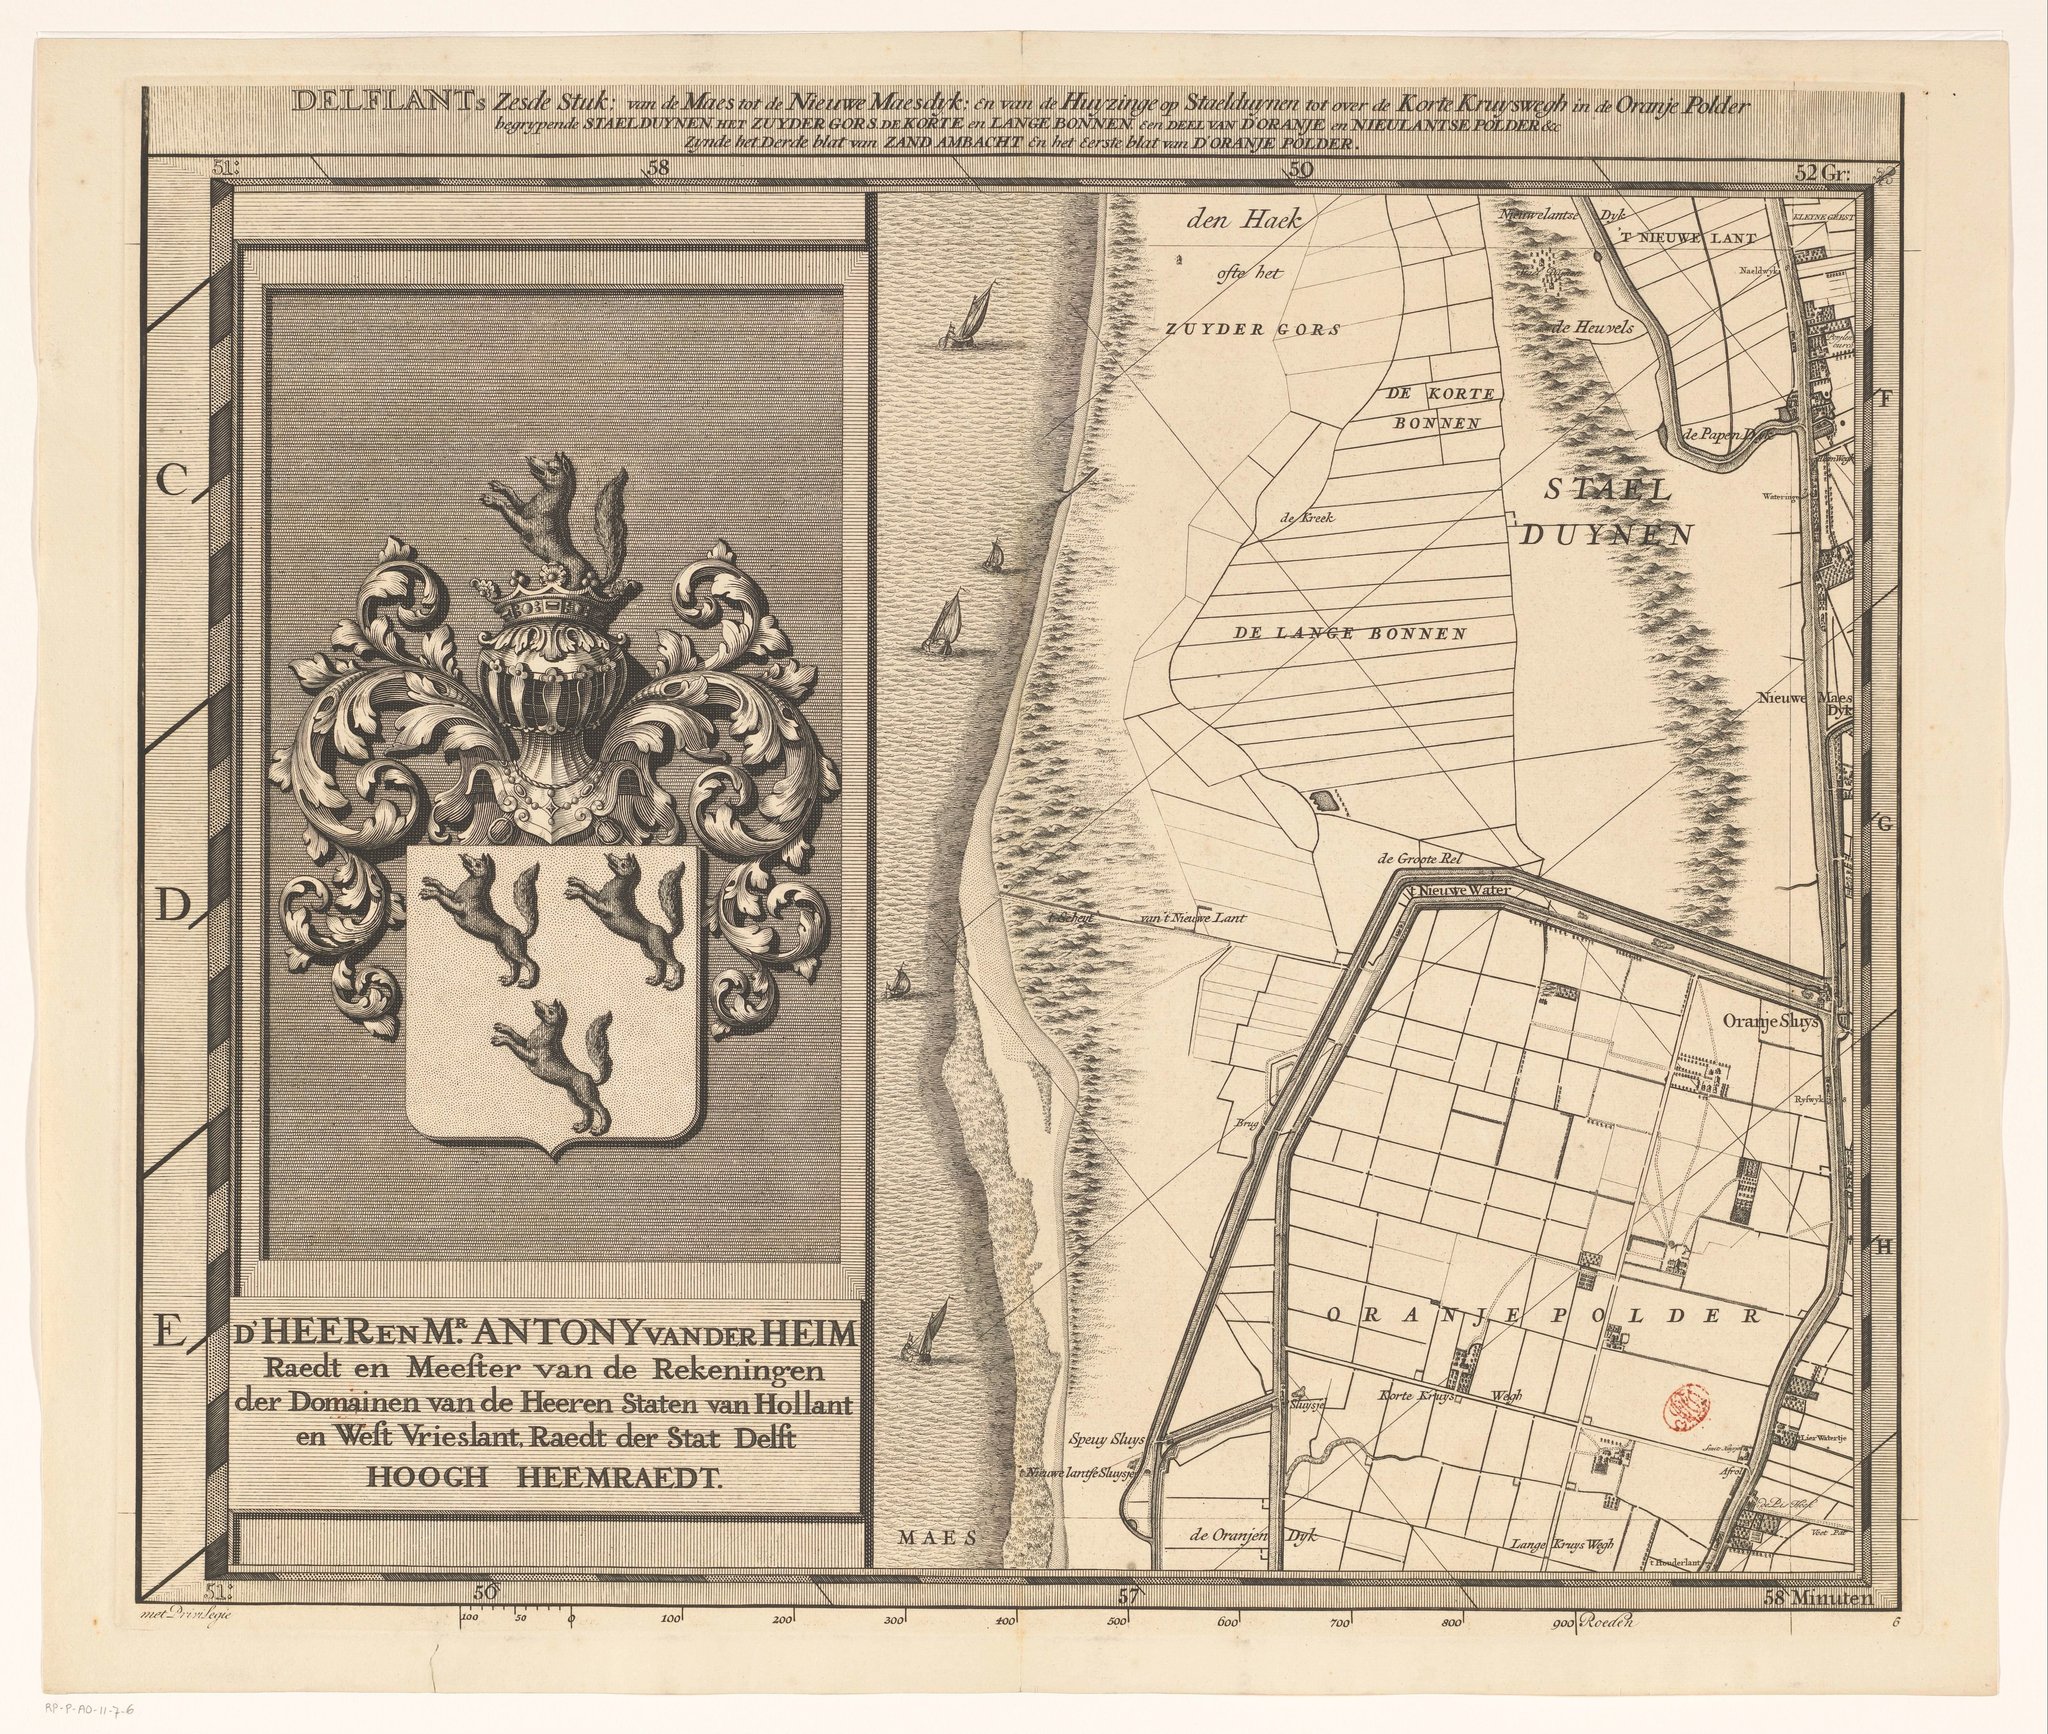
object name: map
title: 'T Hooge Heemraedschap van Delflant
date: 1712-1735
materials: paper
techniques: engraving, etching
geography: delft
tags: maps of cities, armorial bearing, heraldry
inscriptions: collector's mark: Lugt 2228, collector's mark: Lugt 195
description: Onderdeel van de grote wandkaart 'T Hooge Heemraedschap van Delflant. De kaart zelf bestaat uit vijfentwintig bladen, de titelstrook is gedrukt van twee platen. Meerdere prentmakers hebben aan deze kaart gewerkt. In volgorde van meest gewerkte dagen zijn dit: Luggert van Anse (1091 dagen), Thomas Doesburgh (952 dagen), Jacobus Deur (806 dagen), Johannes Deur (683 dagen) en Pieter Sluyter (151 dagen). Sluyter was verantwoordelijk voor de versieringen, de anderen voor de rest. Wie precies aan welk blad heeft gewerkt is niet duidelijk. Pieter Haringh had het ontwerp voor de wapenschilden geleverd en Arnold Houbraken het ontwerp voor de rest van de versieringen. Het drukken, uitgeven en verkopen van de kaart lag, zoals blijkt uit het privilege, in handen van het hoogheemraadschap. Voor zover bekend is de kaart in zijn geheel twee keer gedrukt, in 1712 en 1735. Het hoogheemraadschap beheerde de voorraad kaarten voor verkoop. In een aantal atlassen van Covens & Mortier (Nieuwe atlas inhoudende de vier gedeeltens der waereld (...). 5 delen. Amsterdam: Covens & Mortier, s.a. [1721-1759], dl. 3) zijn de zevenentwintig bladen van de kaart en de overzichtskaart opgenomen. Het is dus vermoedelijk niet zo dat de kaart voor deze atlassen opnieuw werd gedrukt. Waarschijnlijk werd een aantal exemplaren bij het hoogheemraadschap afgenomen.